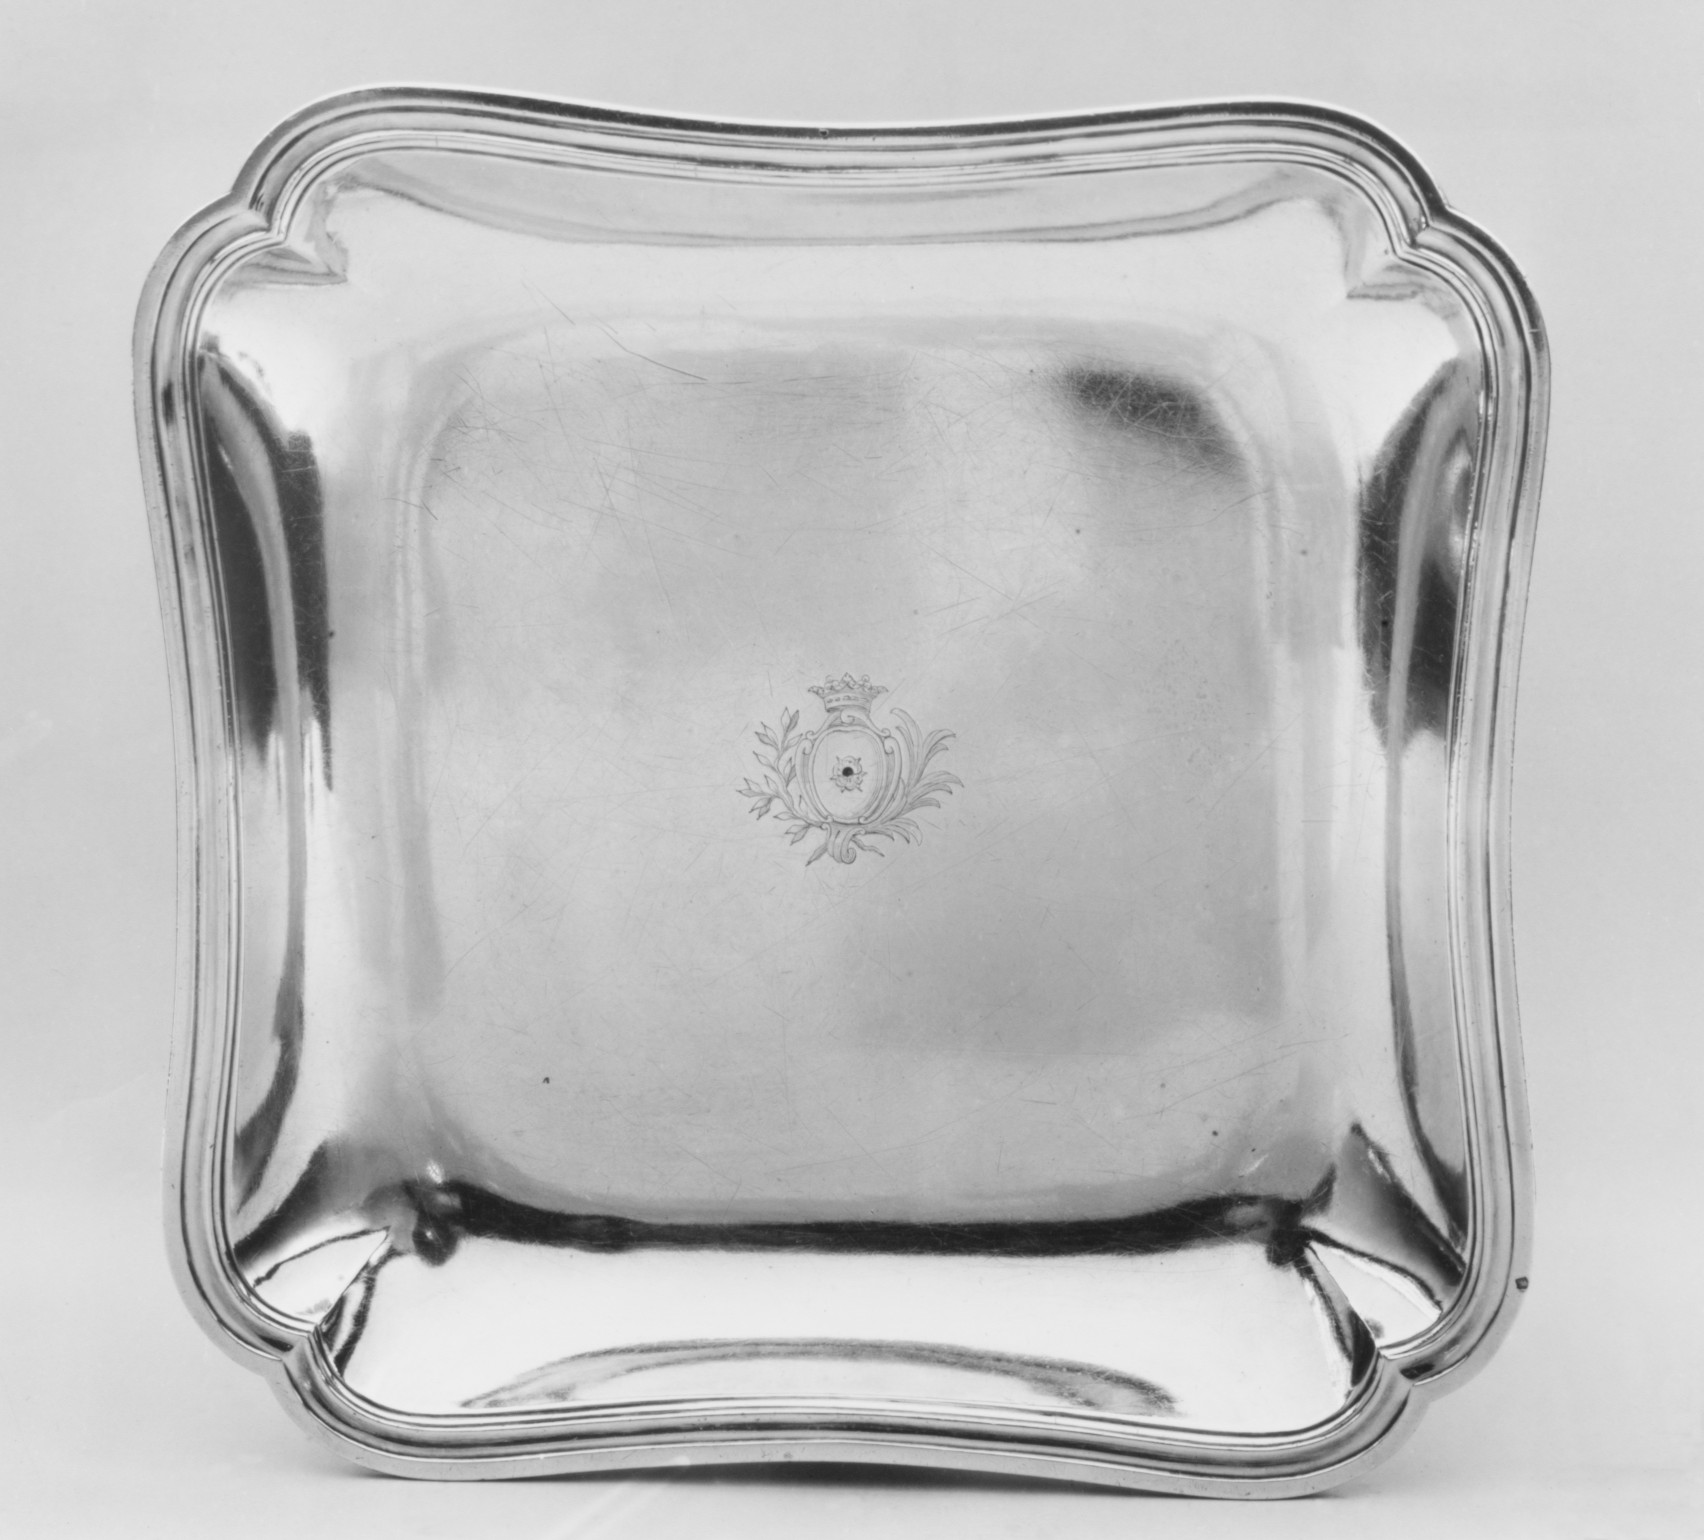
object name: dish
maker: charles-louis-auguste spriman (or spriment)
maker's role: maker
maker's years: 1745-1825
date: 1781-1782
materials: silver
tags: coat of arms